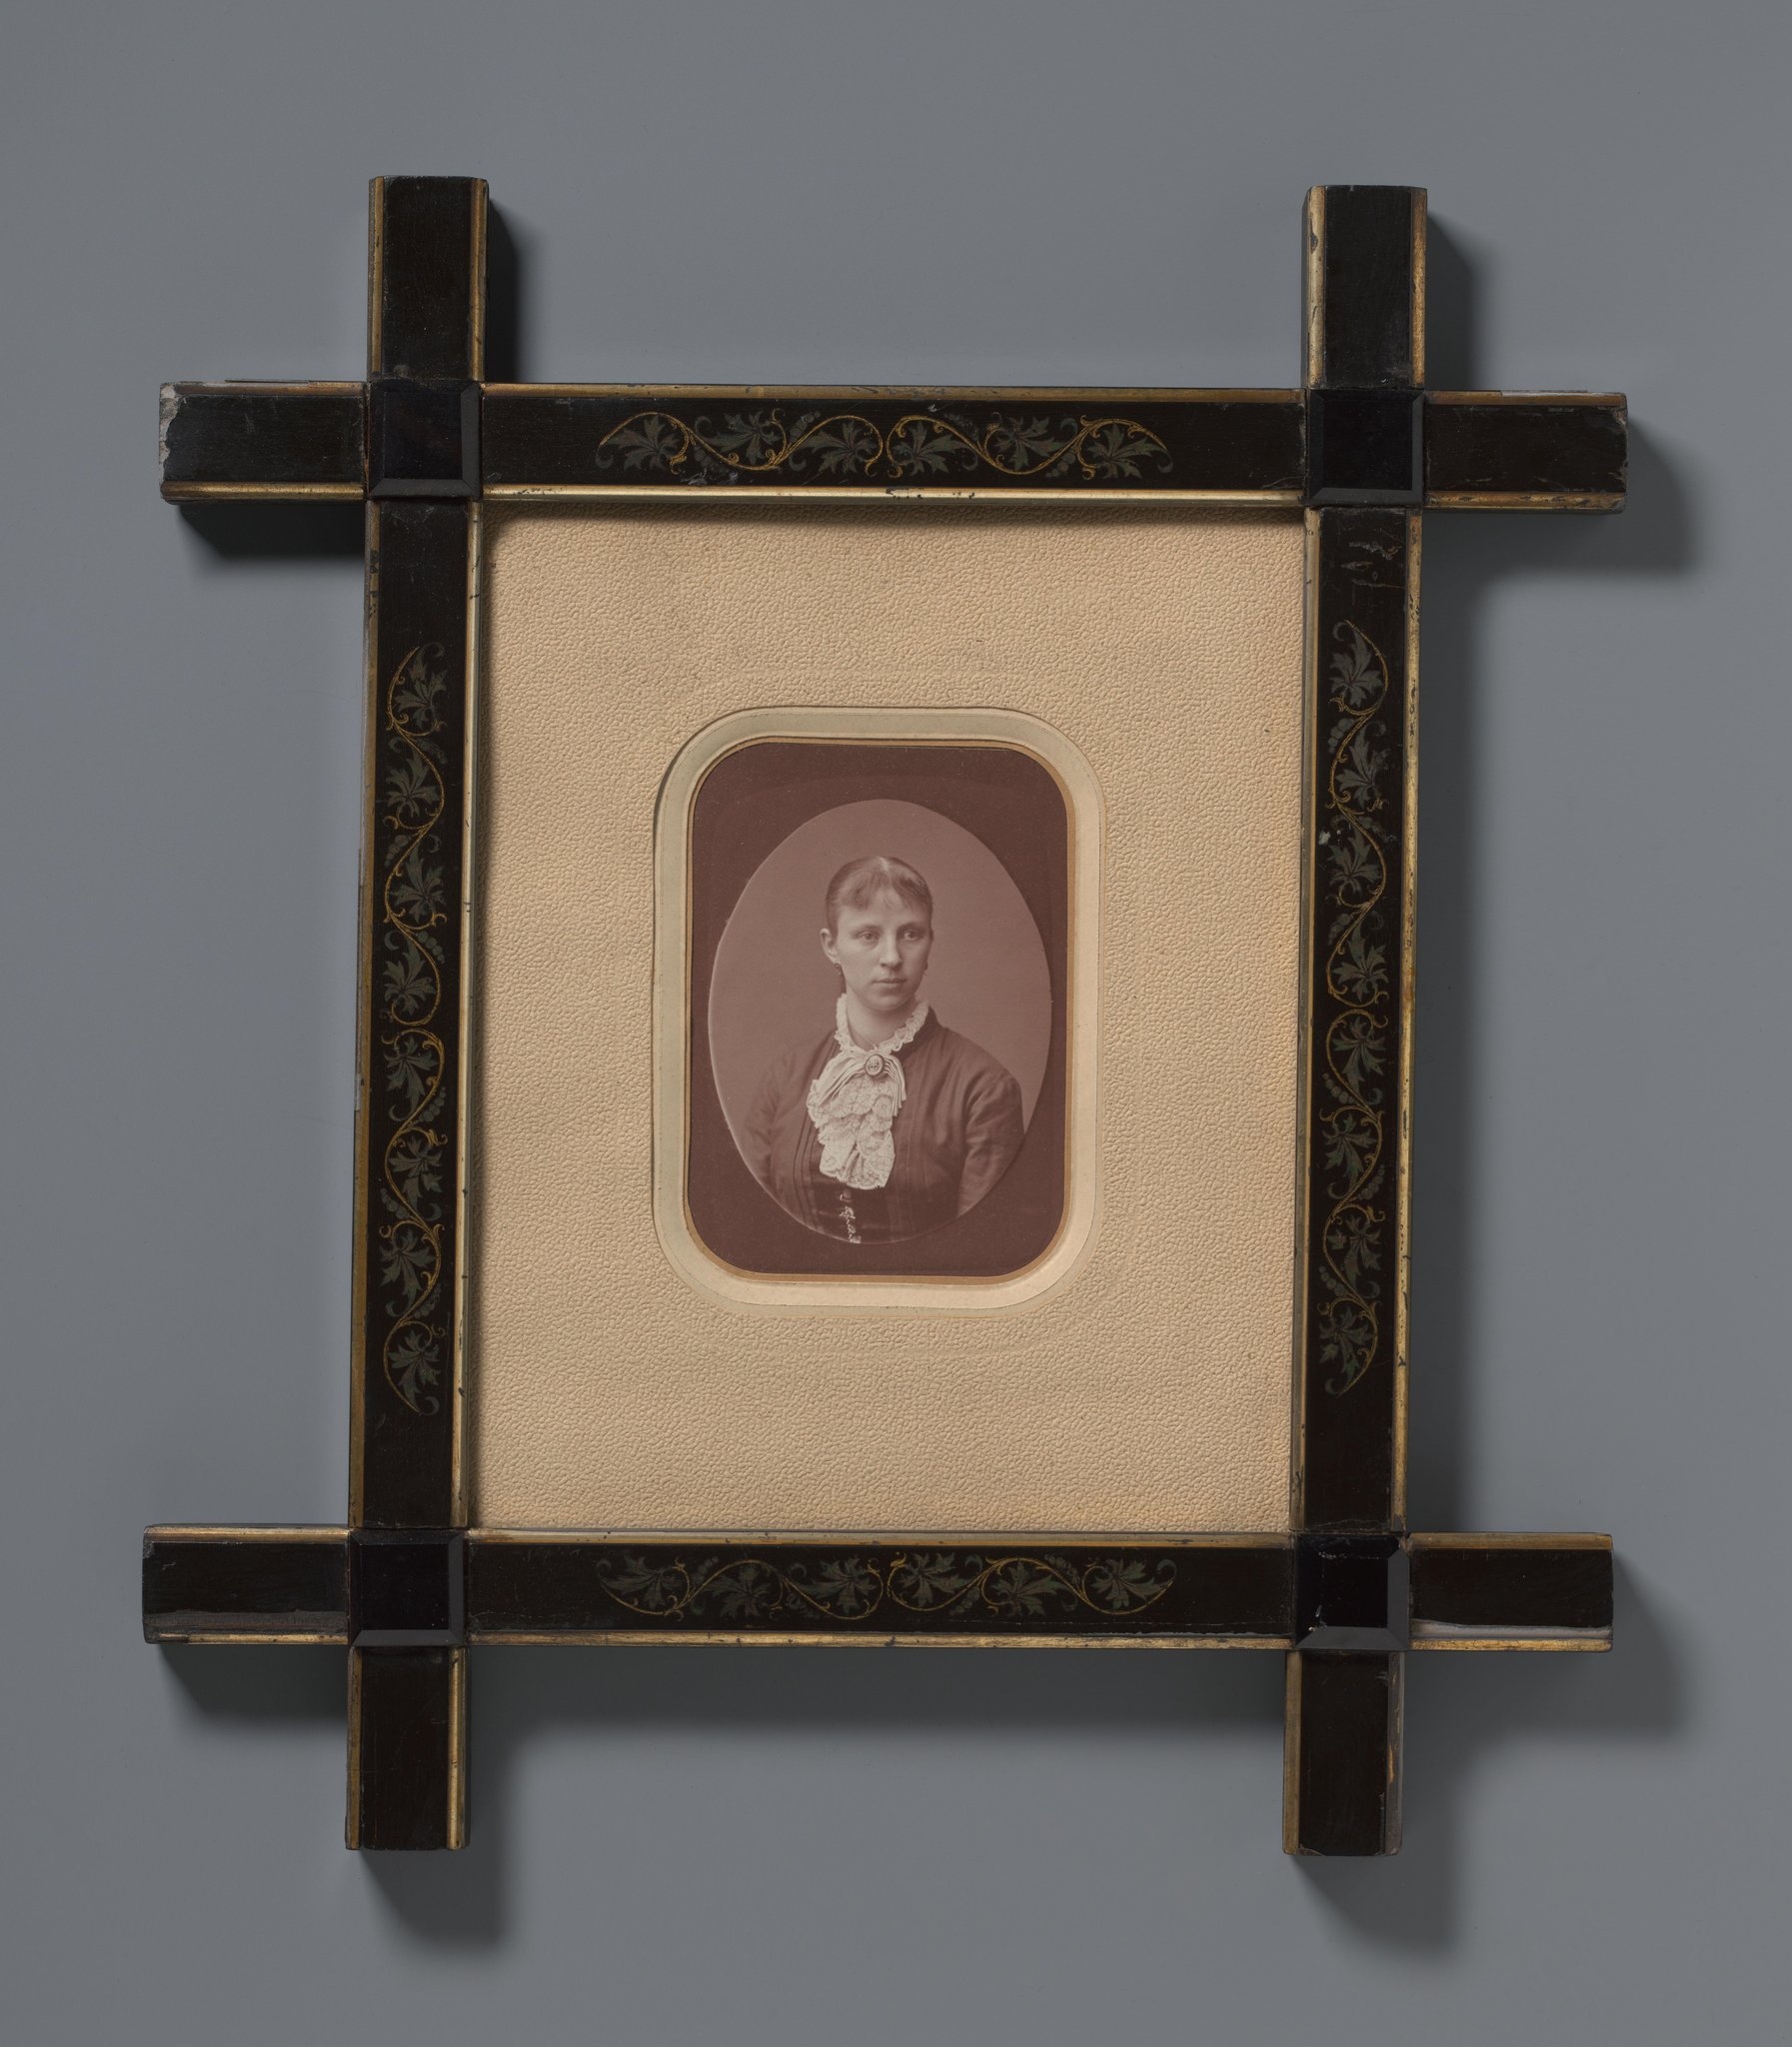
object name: frame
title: Portret van een onbekende jonge vrouw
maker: Anonymous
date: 1897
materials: paper, cardboard, celluloid, glass, metal, wood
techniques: collodion silver print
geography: netherlands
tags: historical persons not known by name - bb - woman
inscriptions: label: ‘M. Hartmann/ Utrechtschestraat, 14/ Spiegels/ en lijsten/ fabriek./ Galeries/ Magazijn van staalgravuren.’